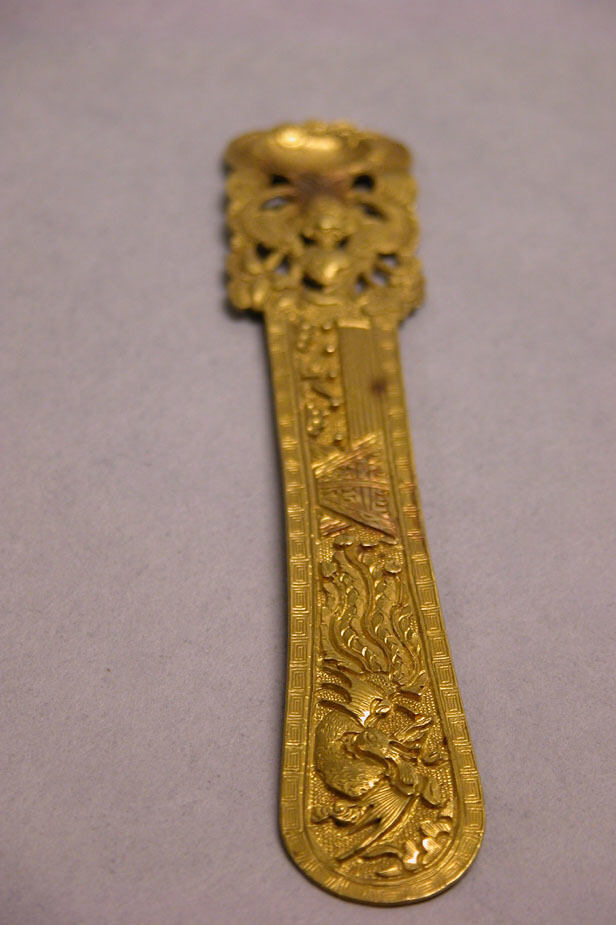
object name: hairpin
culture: chinese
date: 1368-1644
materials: gold